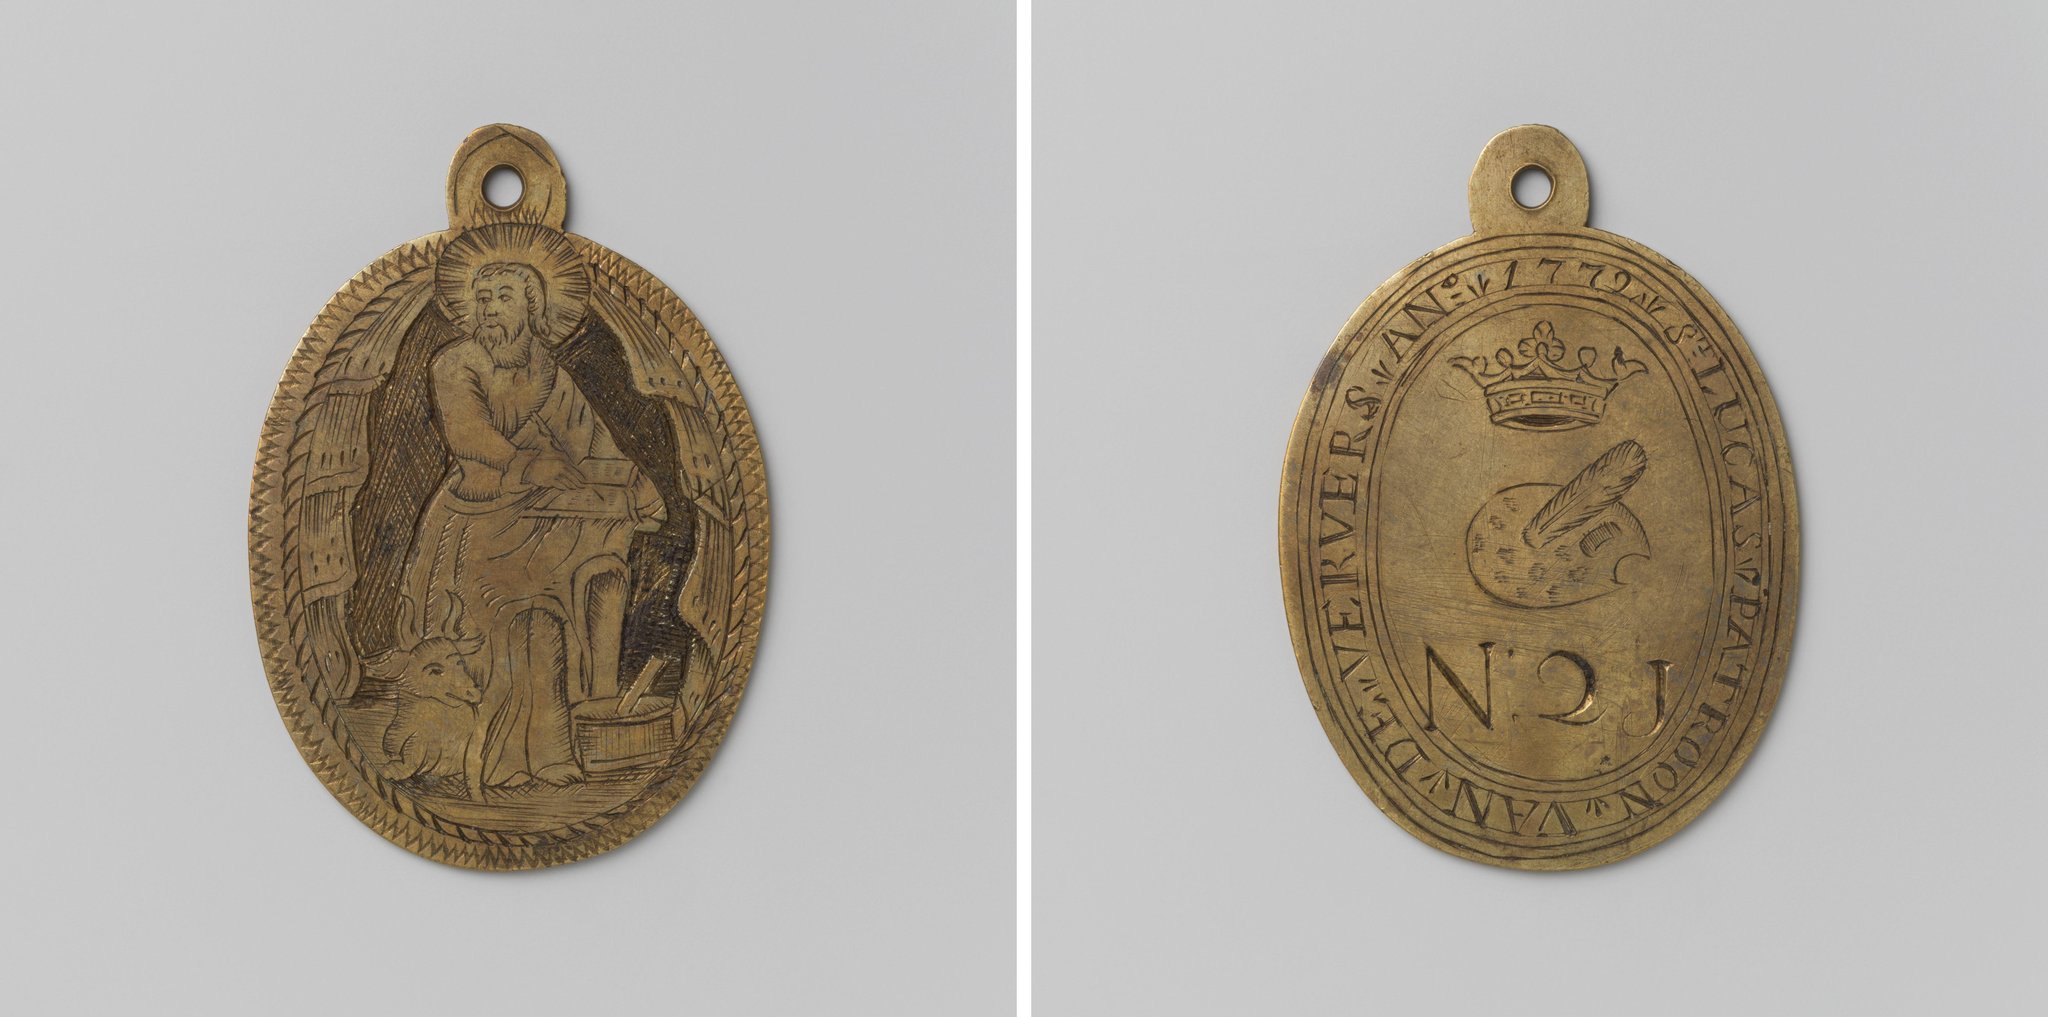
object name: medal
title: Ververs- of St. Lucasgilde van 's-Hertogenbosch, gildepenning met no. 21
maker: Anonymous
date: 1772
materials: brass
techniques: engraving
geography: den bosch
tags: den bosch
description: Guilds were urban organisations of people in specific occupations. The guild represented the interests of the profession. Each member had a token as proof of membership. The person’s name was engraved on one side of the token, often together with the arms of the guild or of the city in which it was based. The other side carried a motif signifying the occupation represented by the guild.